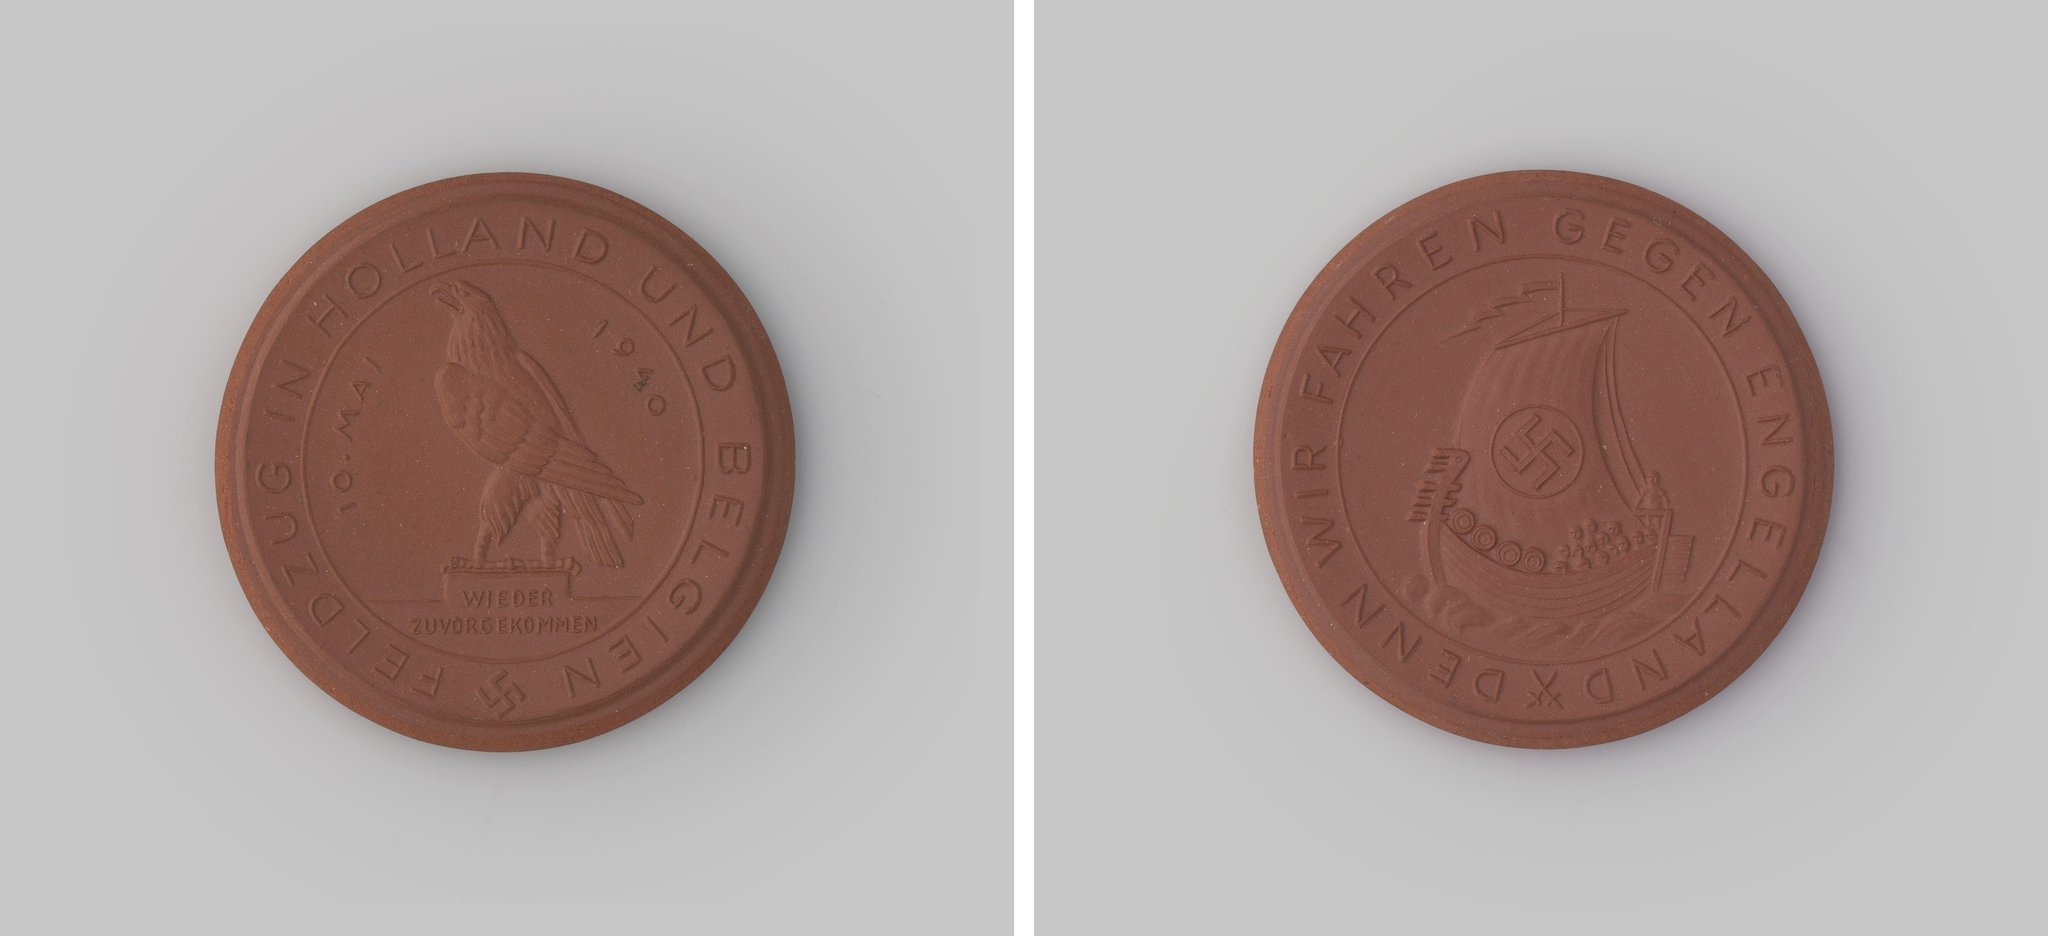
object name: medal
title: German Invasion of the Netherlands and Belgium on 10 May 1940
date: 1940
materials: clay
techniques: striking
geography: meissen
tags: duitse inval in nederland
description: The Rijksmuseum’s medal collection, boasting some 12,500 objects, is almost a century and a half old. The museum continues to expand its collection with special medals, which are either purchased, donated, or given on loan. On display here are a number of the most extraordinary acquisitions of recent years. These are honorary and commemorative medals. Several are unique and came from the descendants of the individuals who once received them.